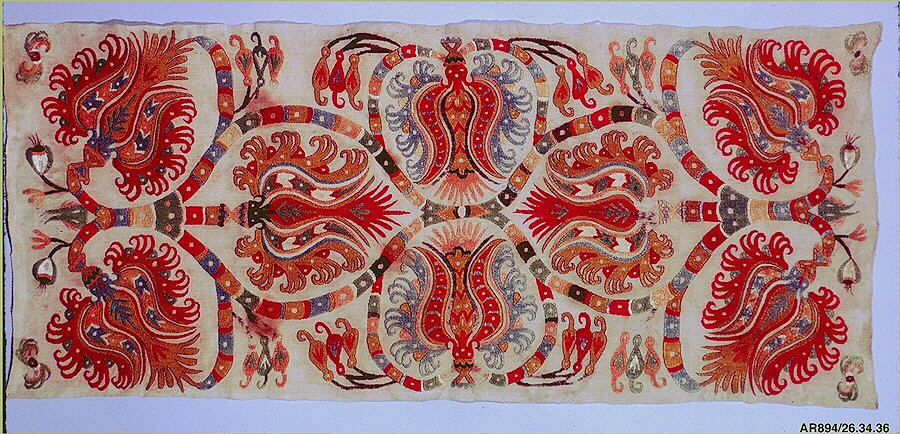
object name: fragment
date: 1701-1800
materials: linen, silk